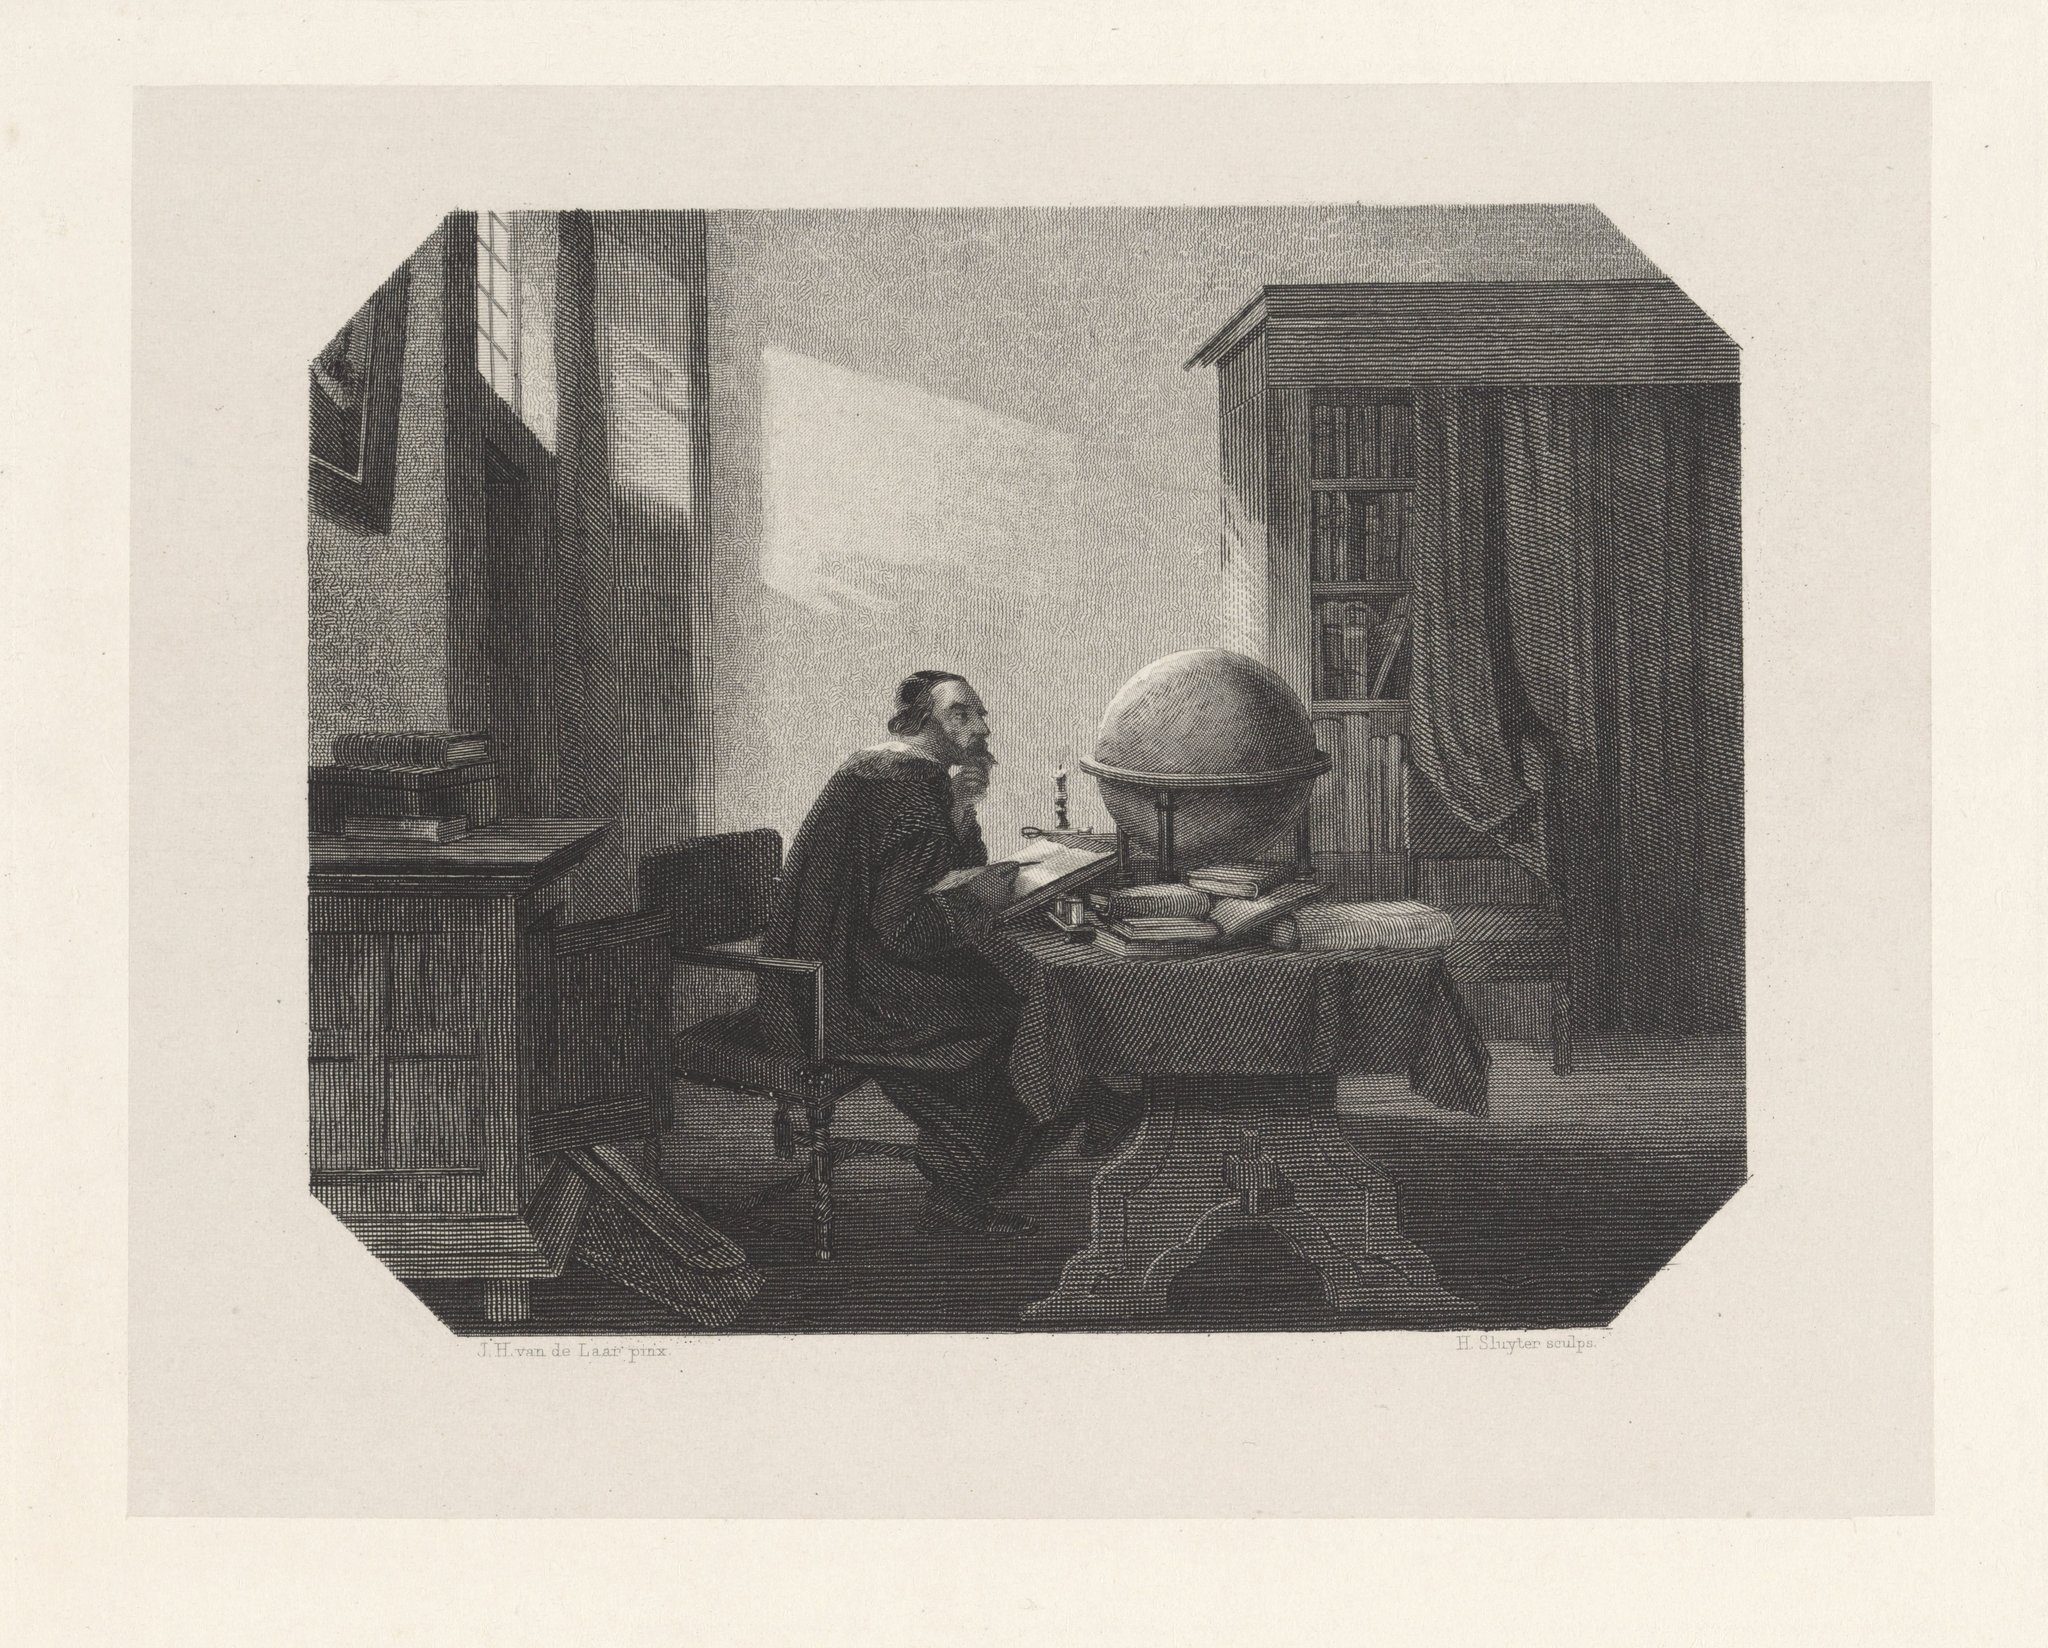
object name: history print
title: Adriaan Adriaansz. Metius in zijn studeerkamer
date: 1865-1870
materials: paper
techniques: etching, engraving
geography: amsterdam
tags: adriaan adriaansz. metius, bookcase, with doors, materials to write on, writing surfaces (+ scholar, scientist (at work)), book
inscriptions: collector's mark: Lugt 2228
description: Illustratie voor: J. van Lennep en W. Moll en J. ter Gouw. Nederlands geschiedenis en volksleven in schetsen. Leiden: A.W. Sijthoff, [ca. 1870]. Staalgravures naar de schilderijen van de Historische Galerij der Maatschappij Arti en Amicitiae.